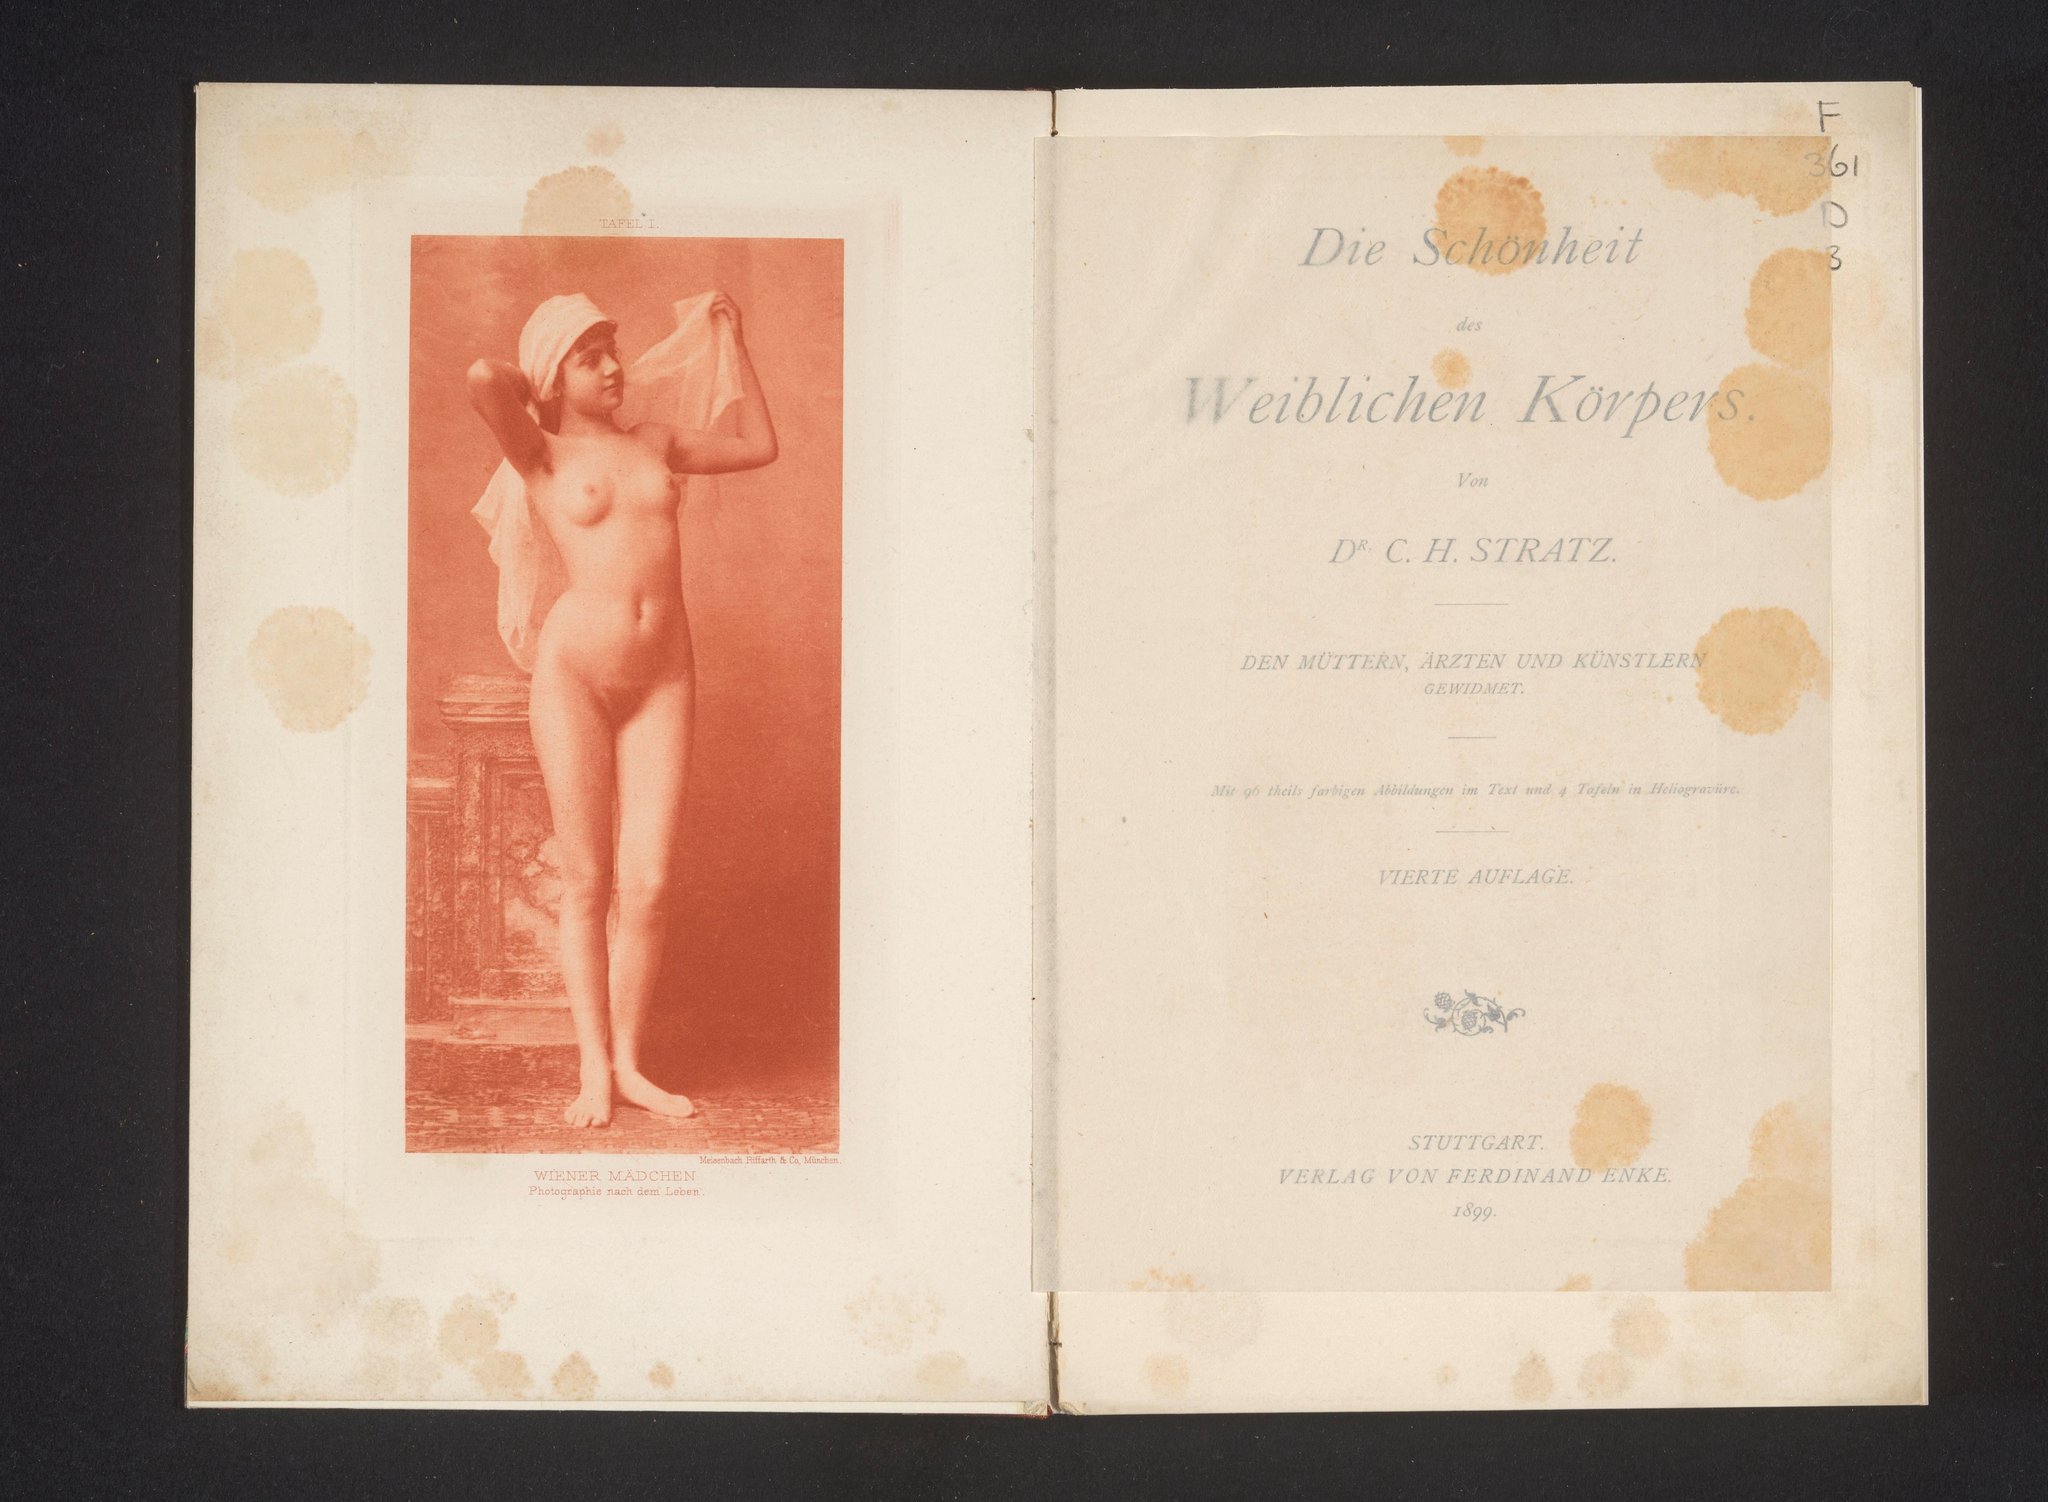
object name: page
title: Standing Female Nude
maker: Anonymous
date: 1894-1899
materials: paper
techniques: photoaquatint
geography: munich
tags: the (nude) human figure; 'corpo humano' (ripa) - aa - female human figure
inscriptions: inscription: ‘Photographie nach dem Leben’, inscription: ‘Tafel I’